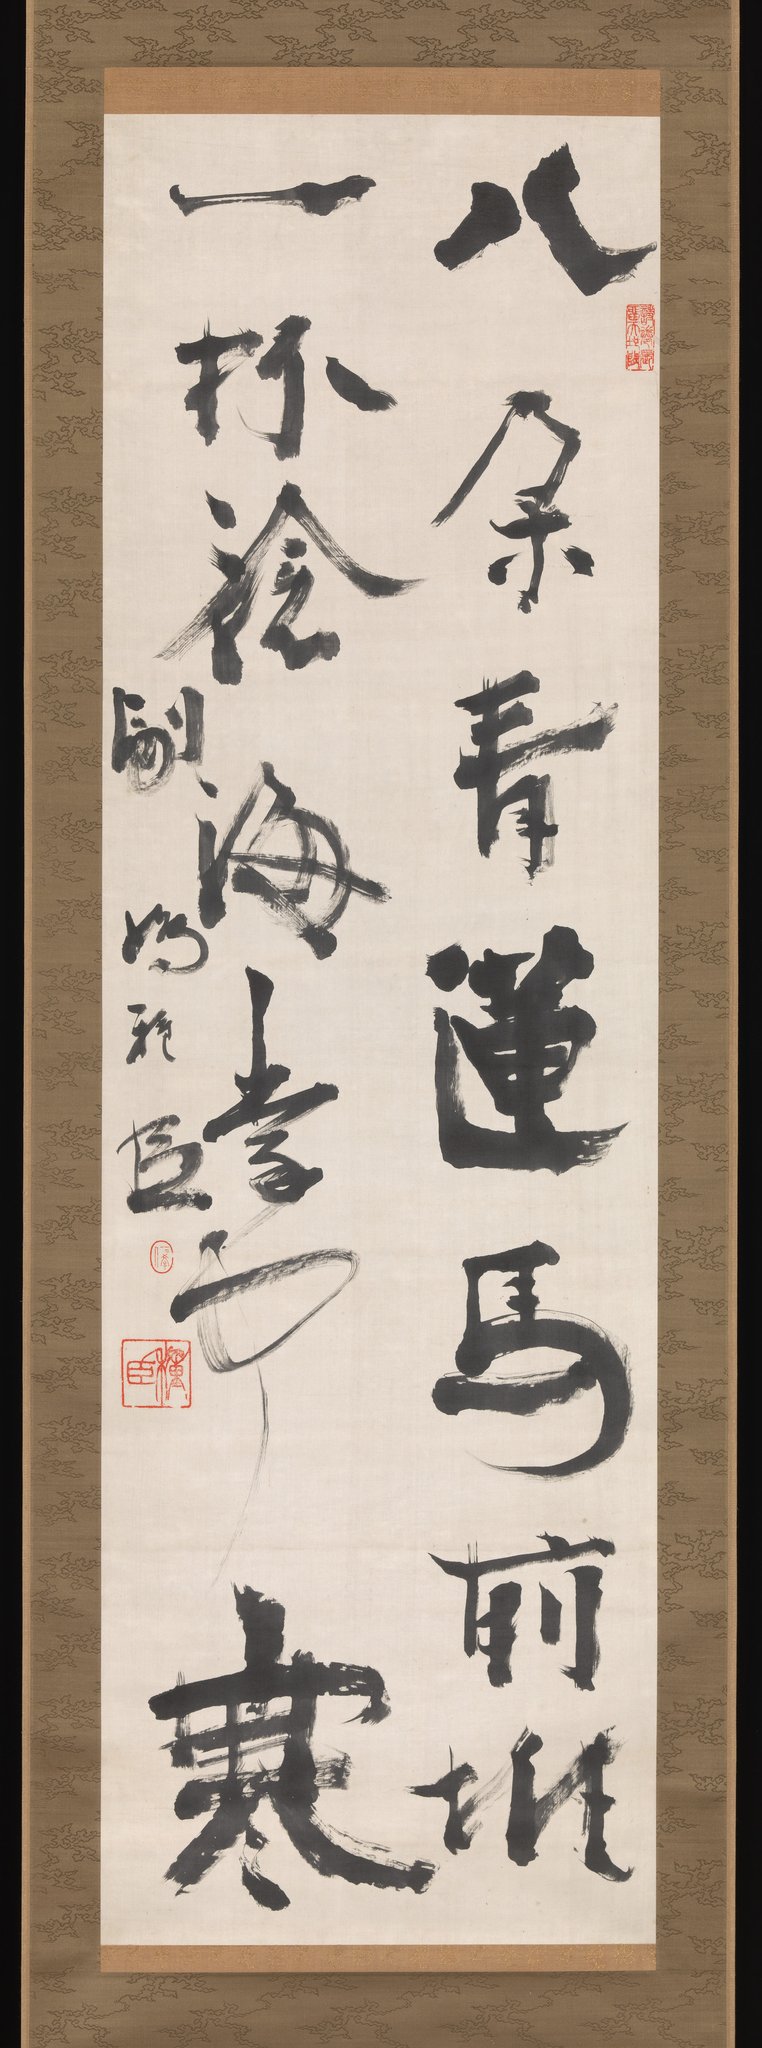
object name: hanging scroll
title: Two-Line Calligraphy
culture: japanese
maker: soejima taneomi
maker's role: artist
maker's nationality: japanese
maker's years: 1828-1905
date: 1615-1905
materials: ink, textile